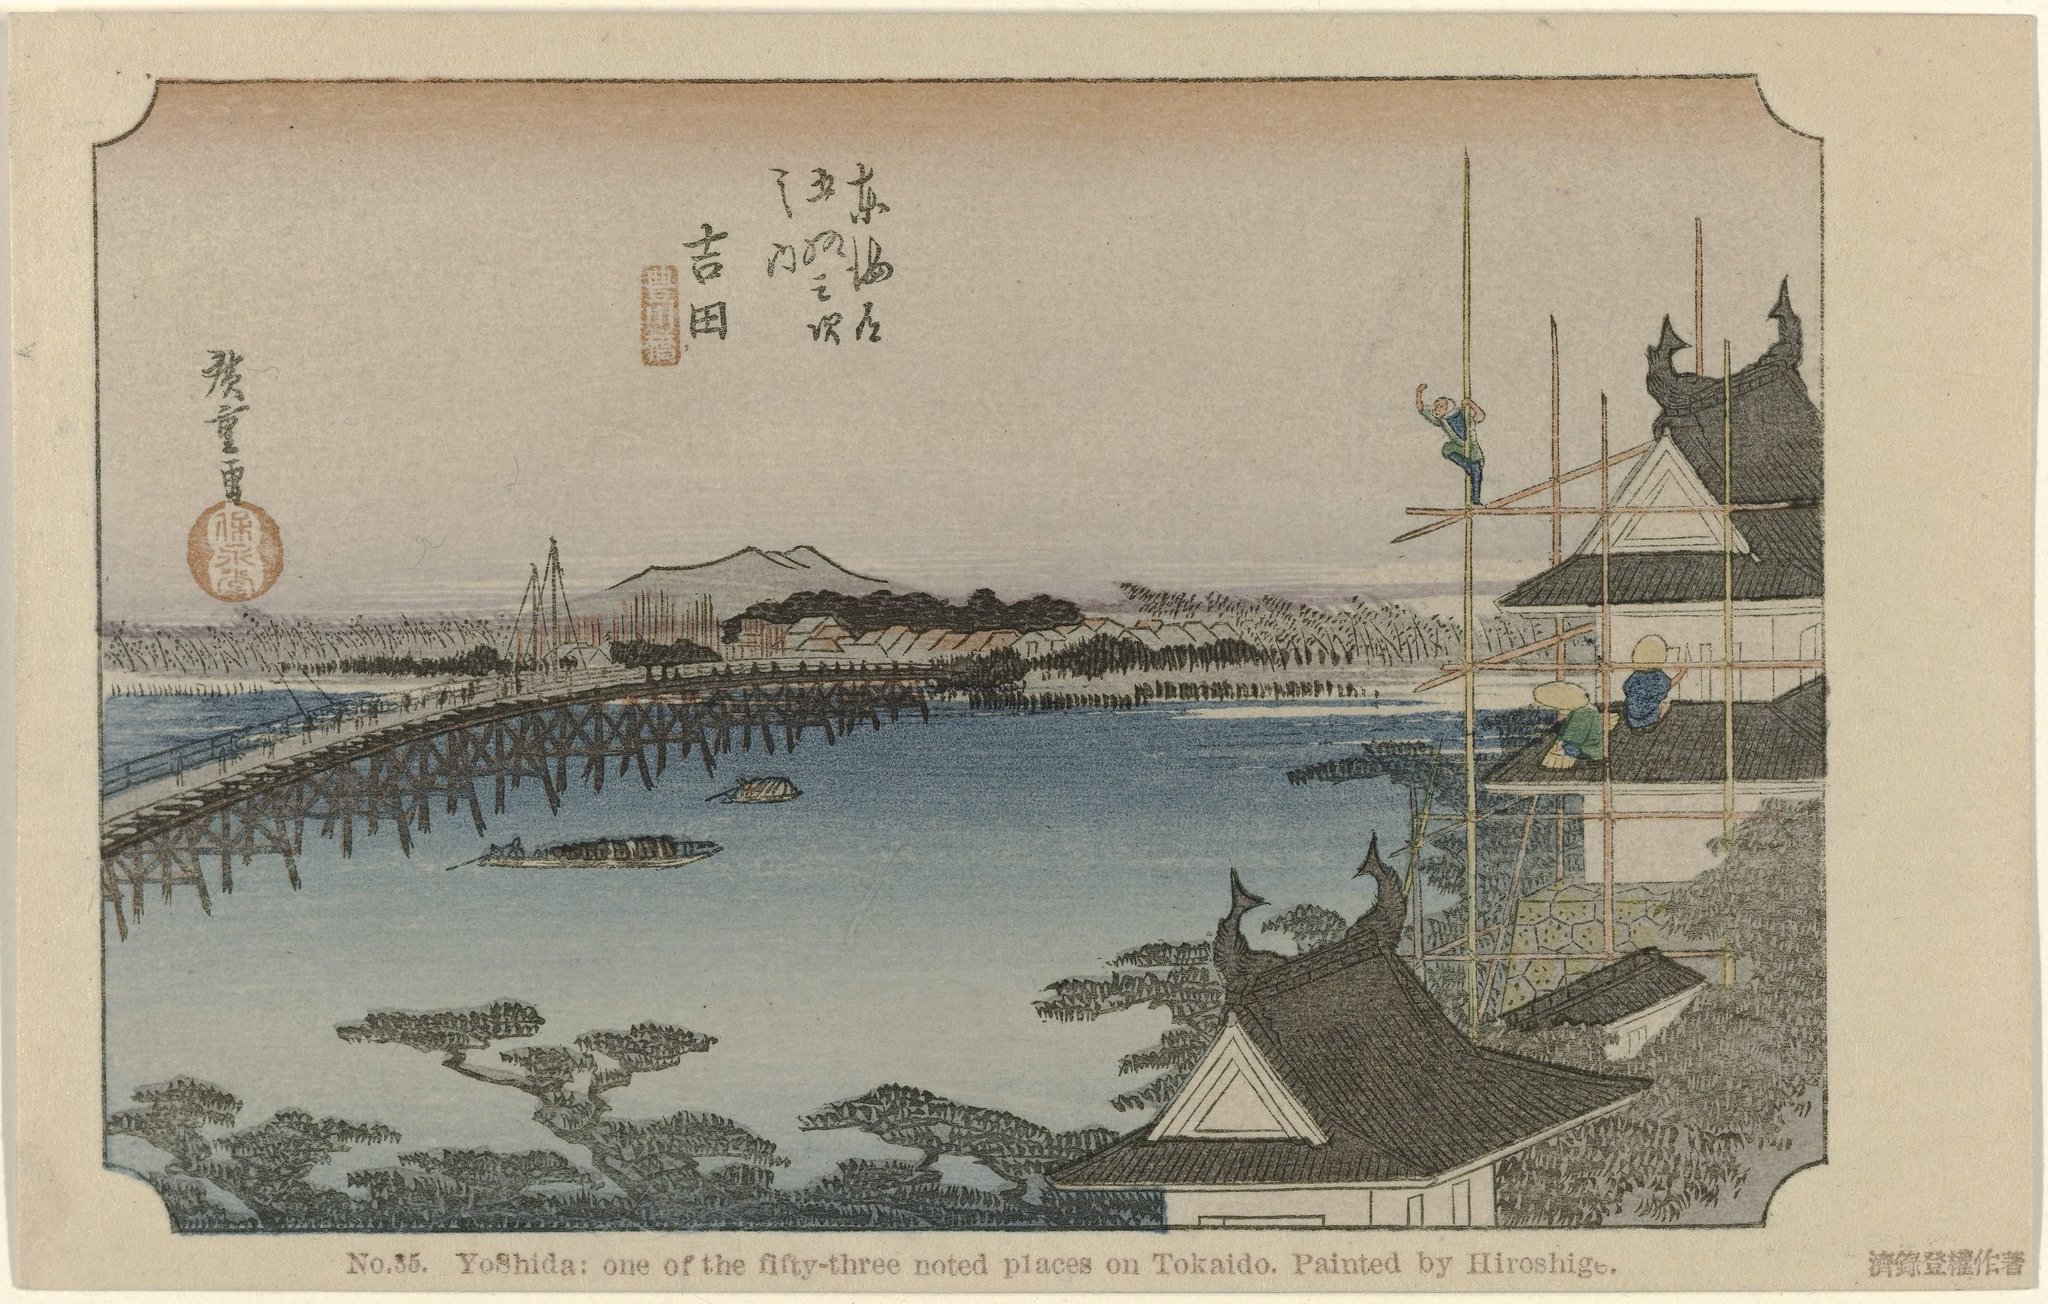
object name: ansichtkaart, prentbriefkaart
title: De Tôkaidô van Hiroshige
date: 1906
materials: cardboard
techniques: woodcut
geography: japan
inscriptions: date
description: Gezicht op de Toyo rivier, waar een lange brug over strekt. Rechts repareren mannen het kasteel van Yoshida.